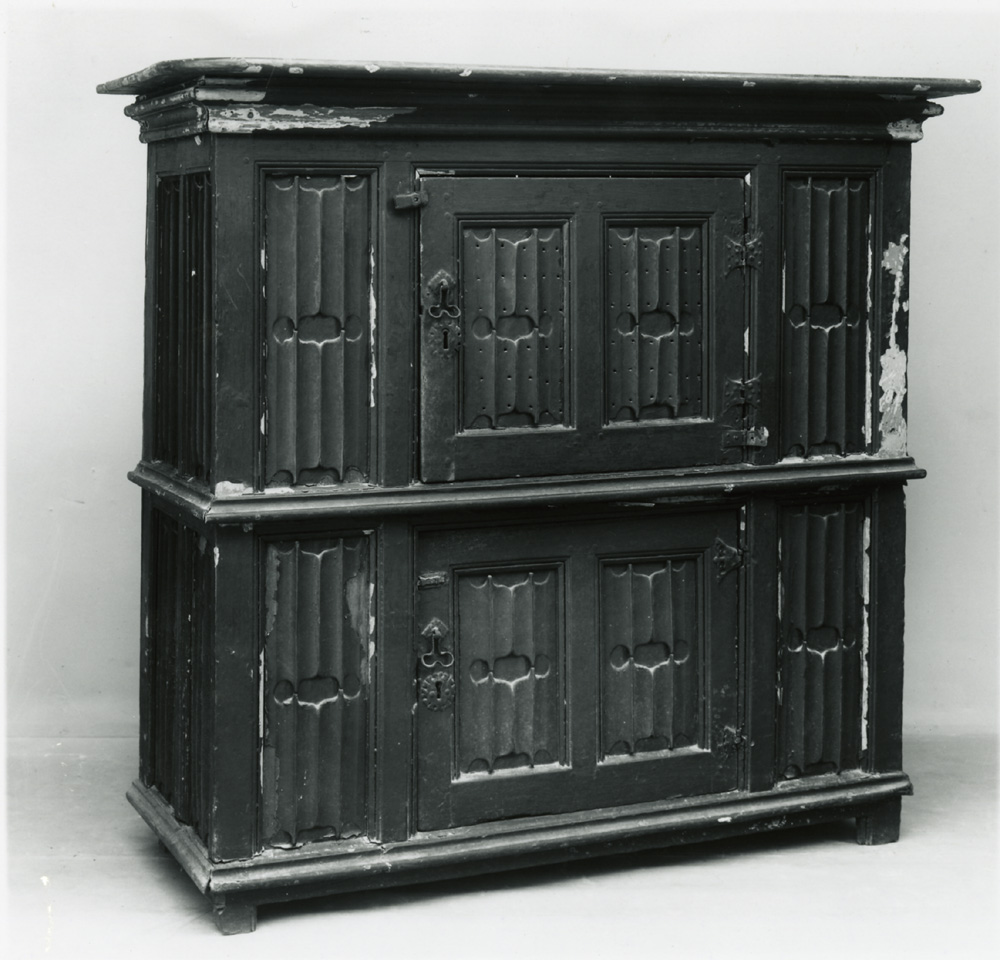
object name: cupboard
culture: dutch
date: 1401-1600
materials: wood